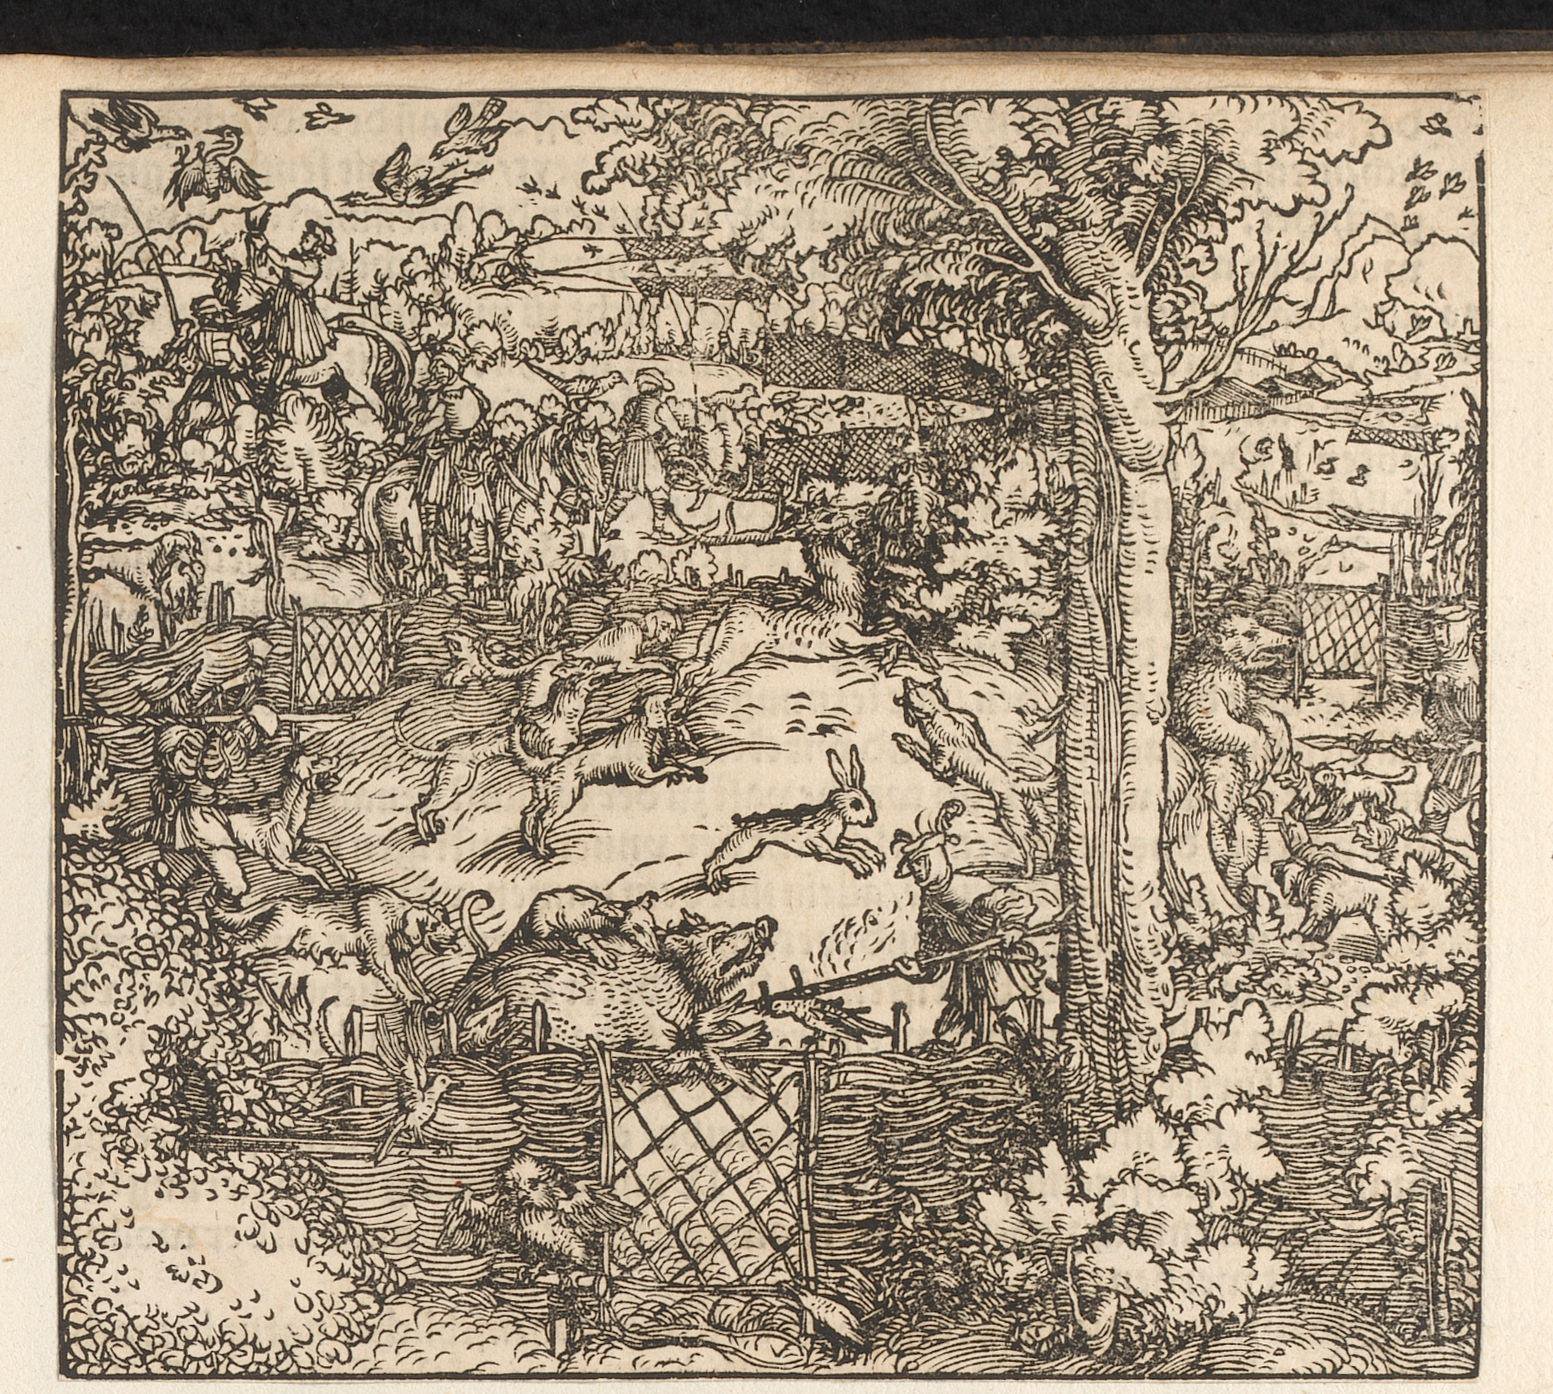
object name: book illustration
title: Jacht op zwijnen en konijnen in de hagen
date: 1514-1532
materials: paper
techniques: letterpress printing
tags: hunting dogs, boar-hunting, hare-hunting, rabbit-hunting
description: Deze prent is gebruikt in: Petrarca, Francesco. Von der Artzney bayder Glück, des guten und widerwertigen: unnd weß sich ain yeder inn Gelück und Unglück halten sol (...). Augsburg: Heinrich Steiner, 1532. Deze uitgave is ook bekend onder de titel 'Trostspiegel in Glück und Unglück'. Deze prent is ook gebruikt in: Cicero, Marcus Tulius. Officia M.T.C. Ein Buch so Marcus Tullius Cicero der Römer zu seynem (...). [Vertaald uit het Latijn door] Johann von Schwarzenberg. Augsburg: Heinrich Steiner, 1531.